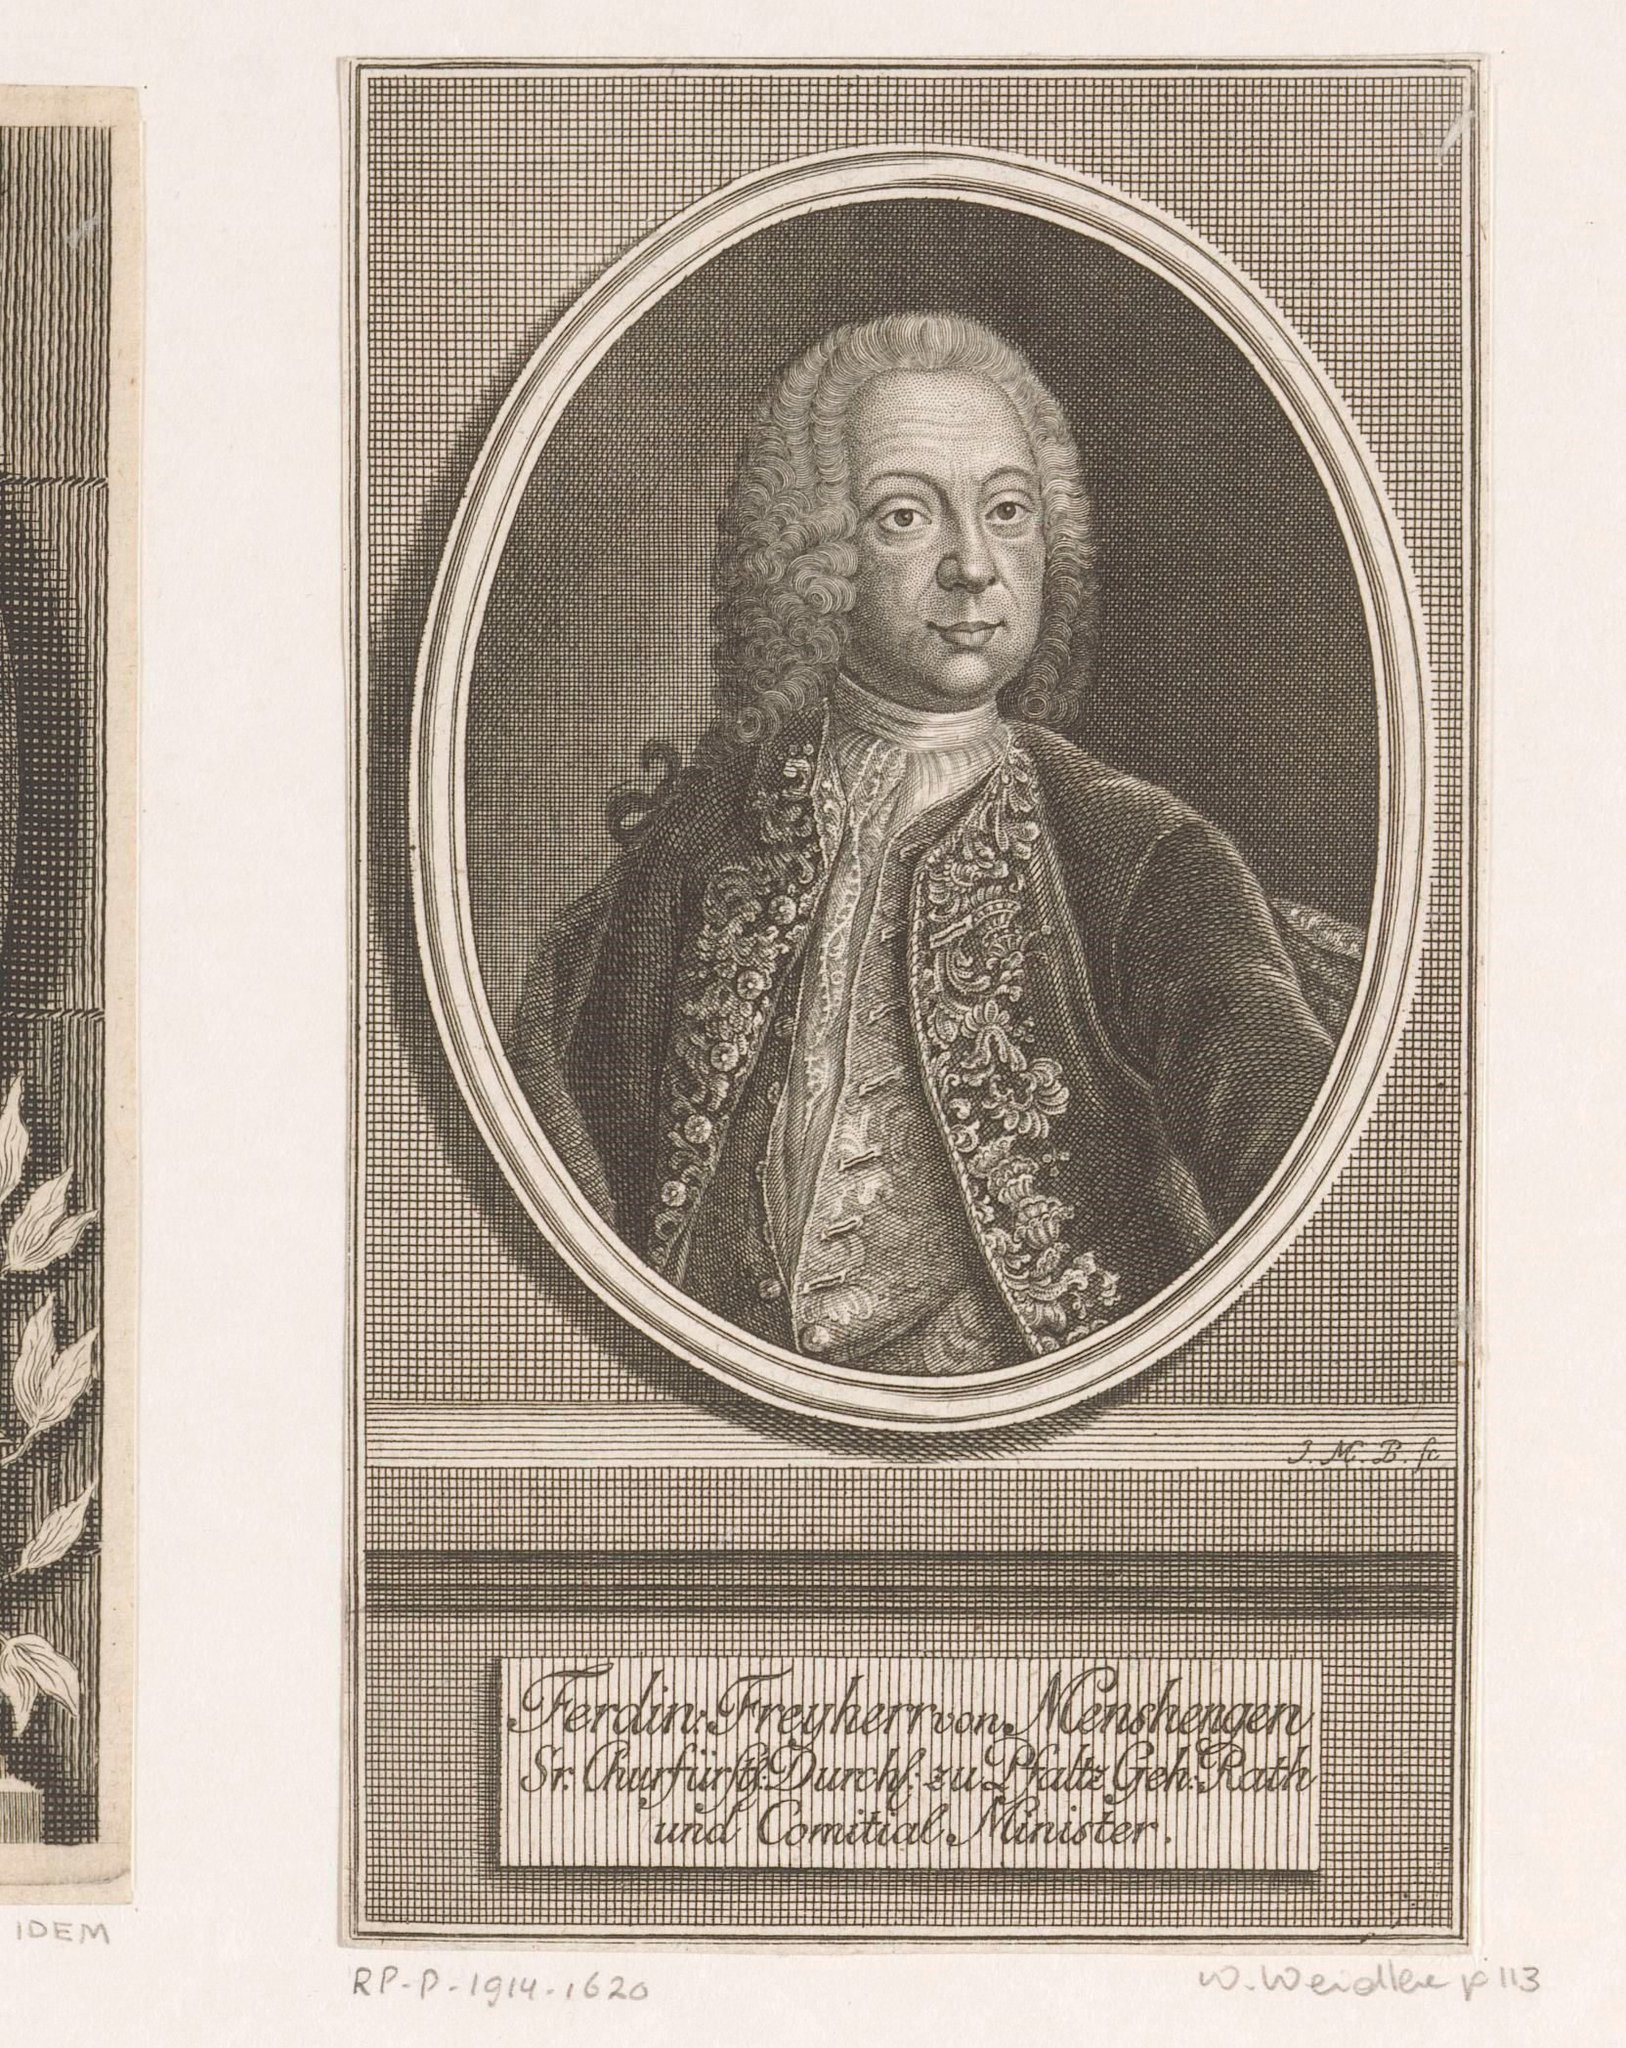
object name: print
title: Portret van Ferdinand, Freiherr von Menshengen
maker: johann martin bernigeroth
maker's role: print maker, publisher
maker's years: 1713-1767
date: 1747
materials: paper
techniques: engraving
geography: leipzig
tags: historical persons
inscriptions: collector's mark: Lugt 2228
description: Prent ook gebruikt in: Die Neue Europäische Fama, Welche den gegenwärtigen Zustand der vornehmsten Höfe entdecket. dl. 148. Leipzig: Gleditsch, 1747.